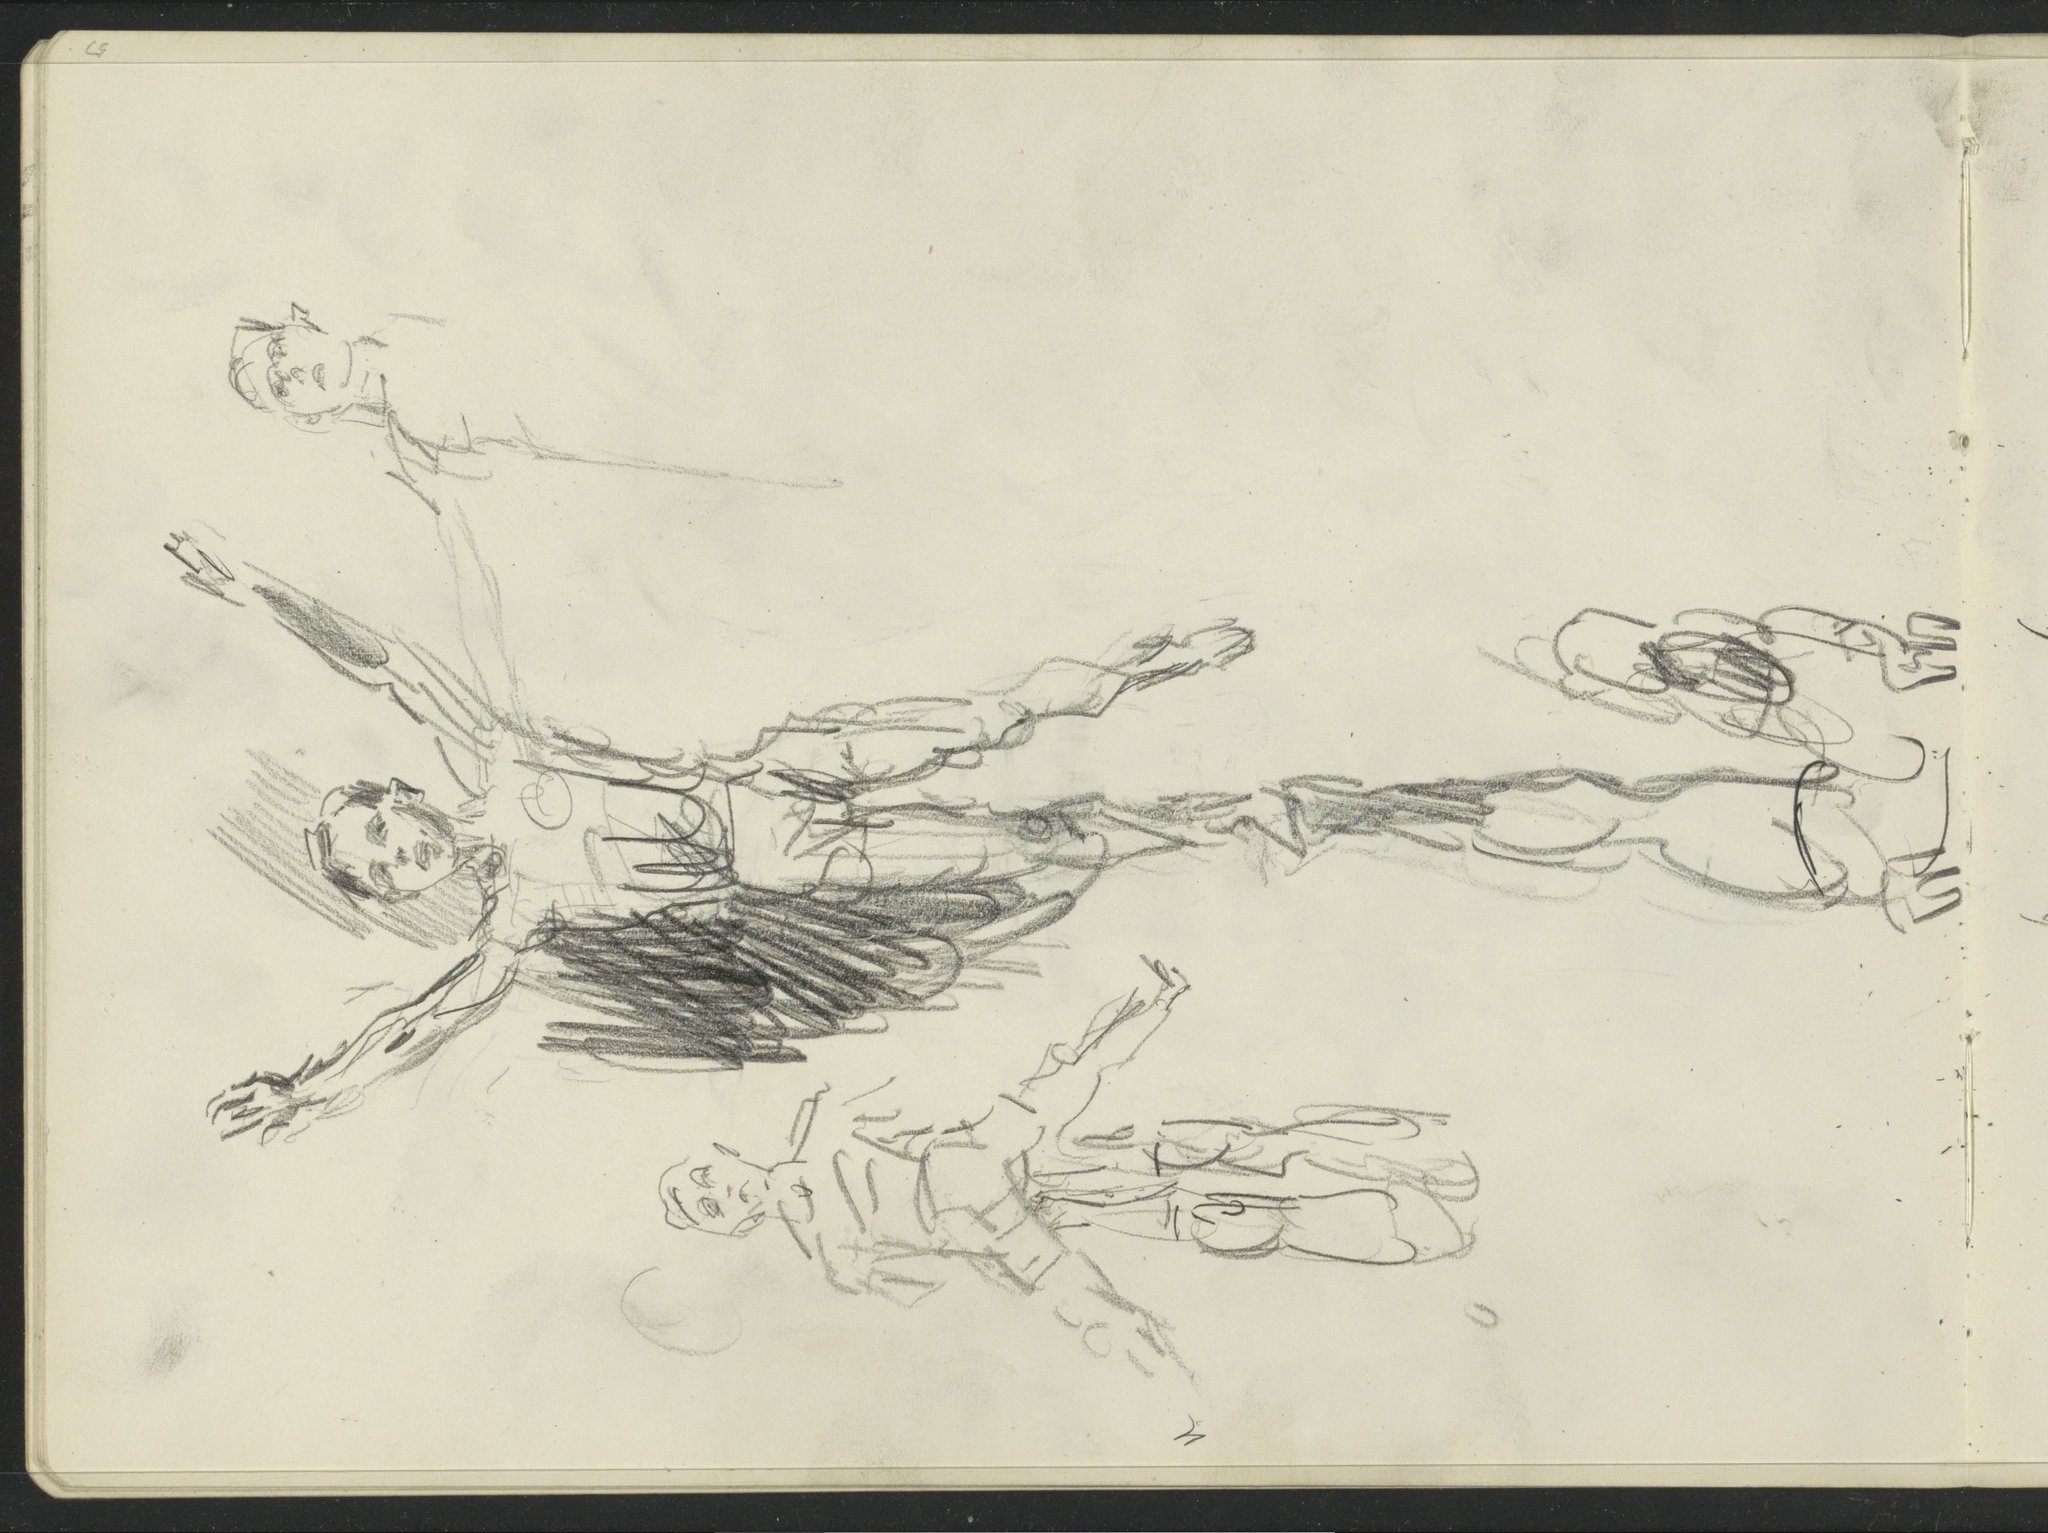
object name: sketchbook leaf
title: Studieblad met acrobaten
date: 1915-1934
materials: paper, pencil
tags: acrobat ~ circus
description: De acrobaten balanceren in duo's op elkaars benen. Blad 14 verso uit schetsboek XVI met 32 bladen.